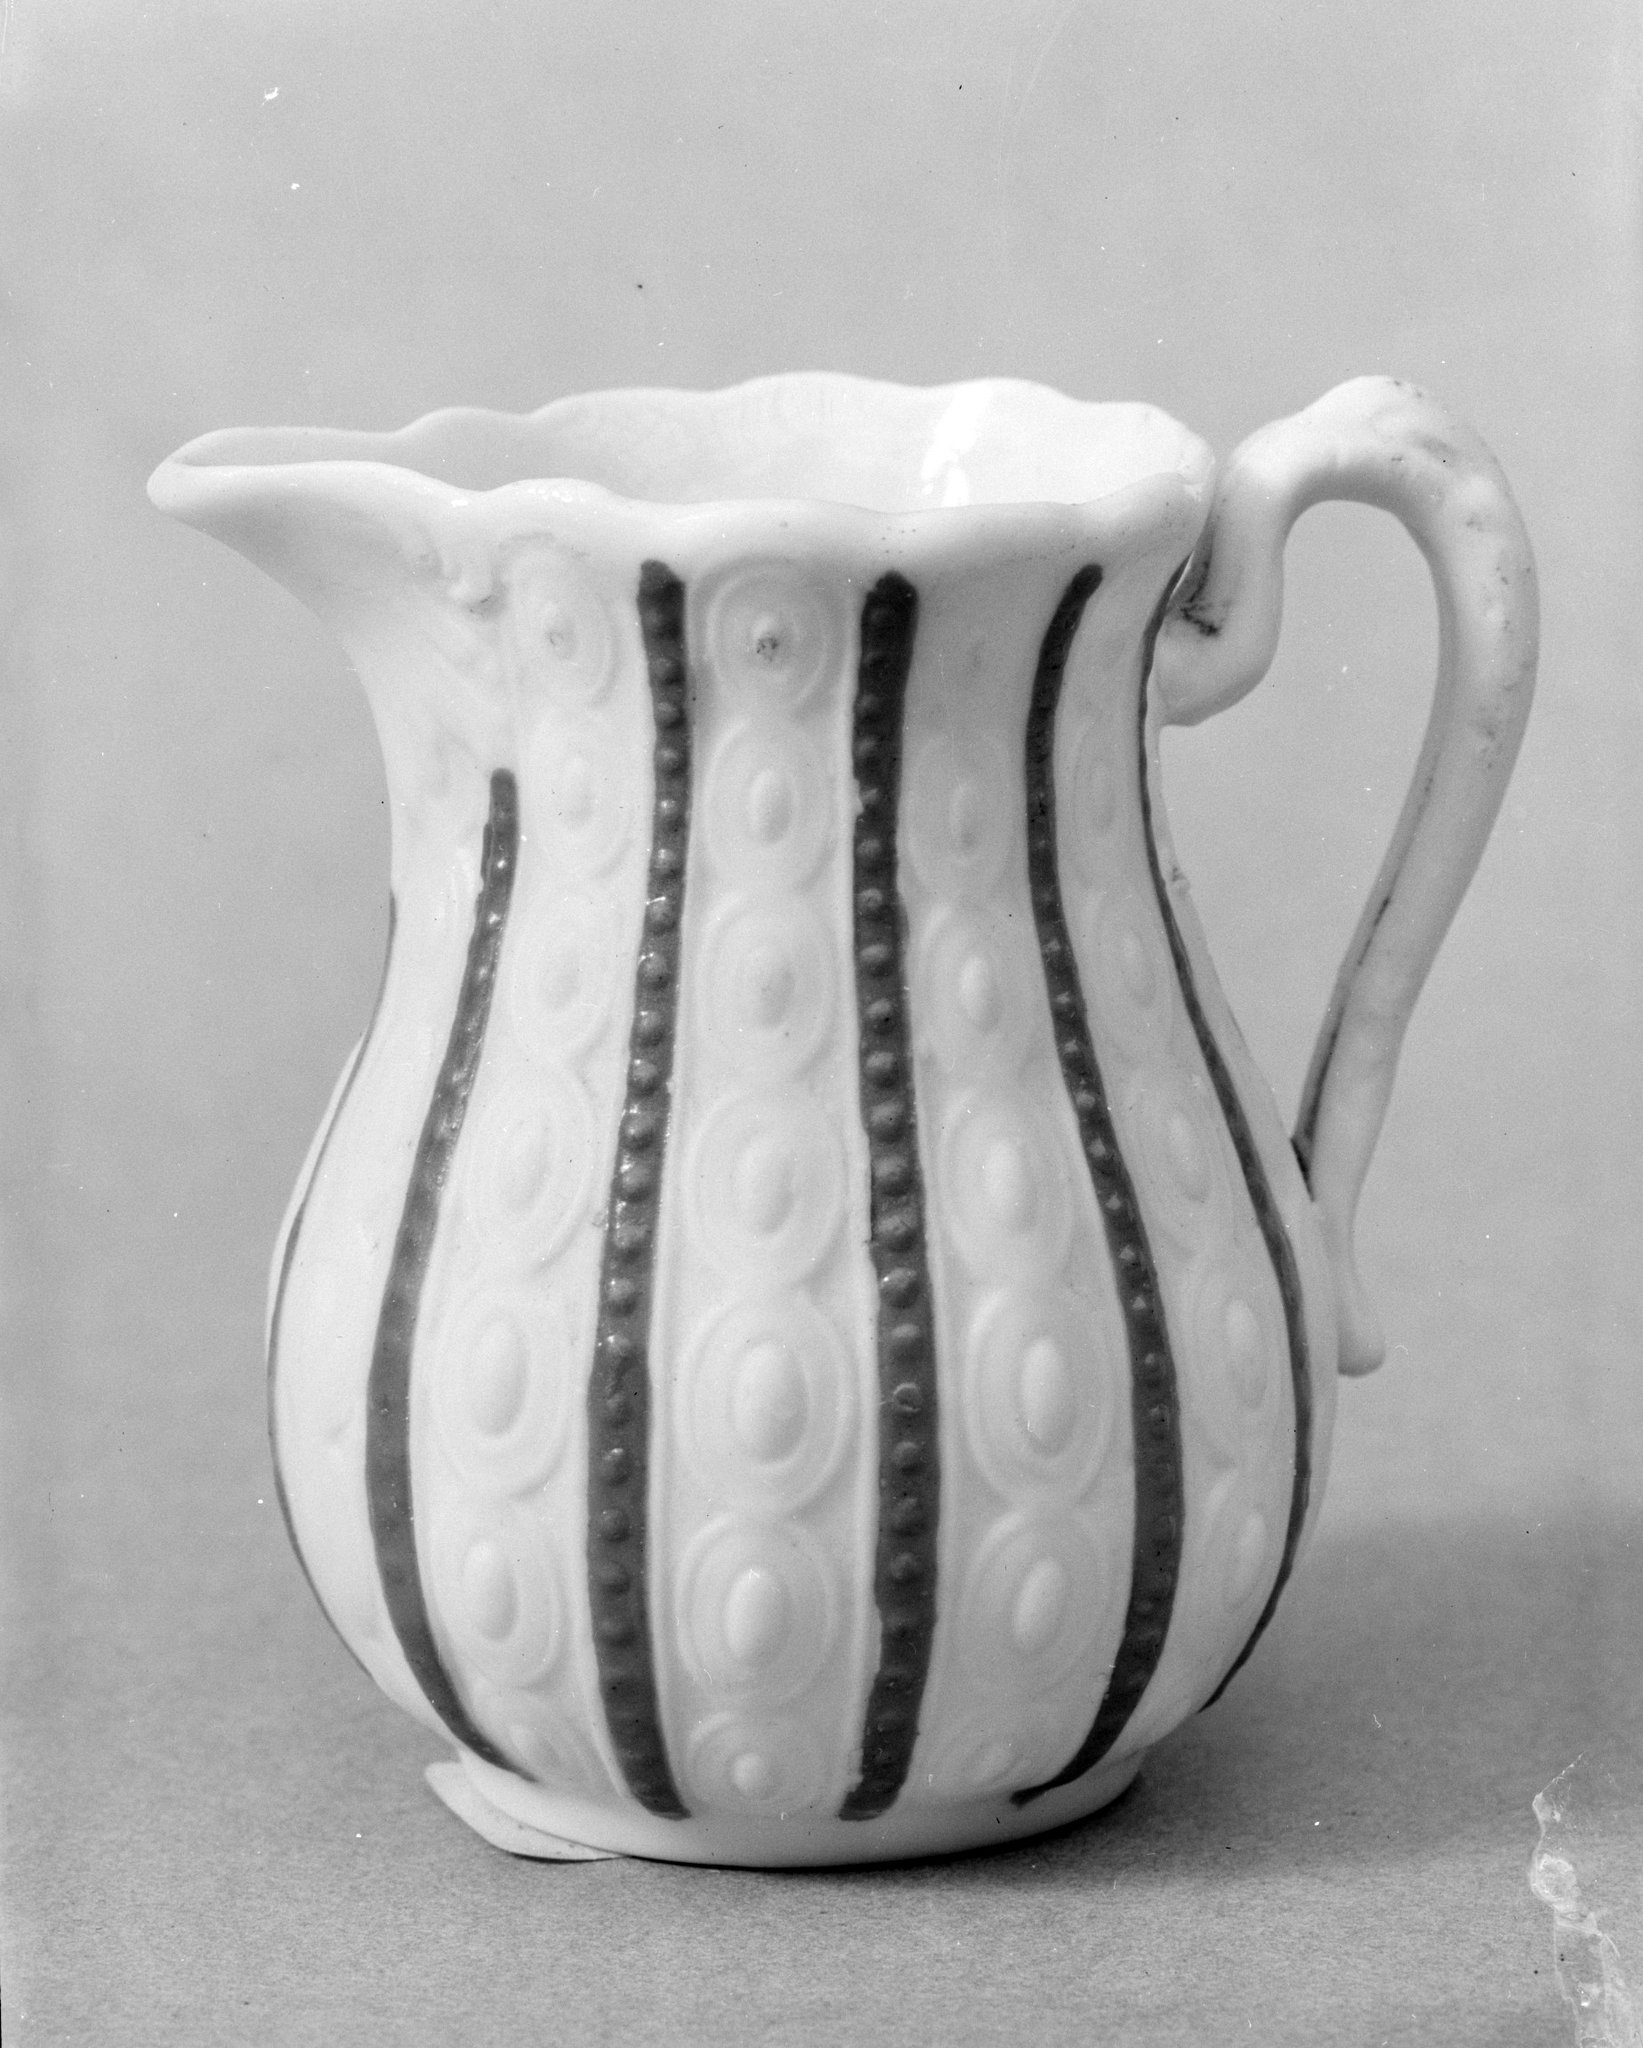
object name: pitcher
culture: american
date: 1830-1870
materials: porcelain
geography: united states